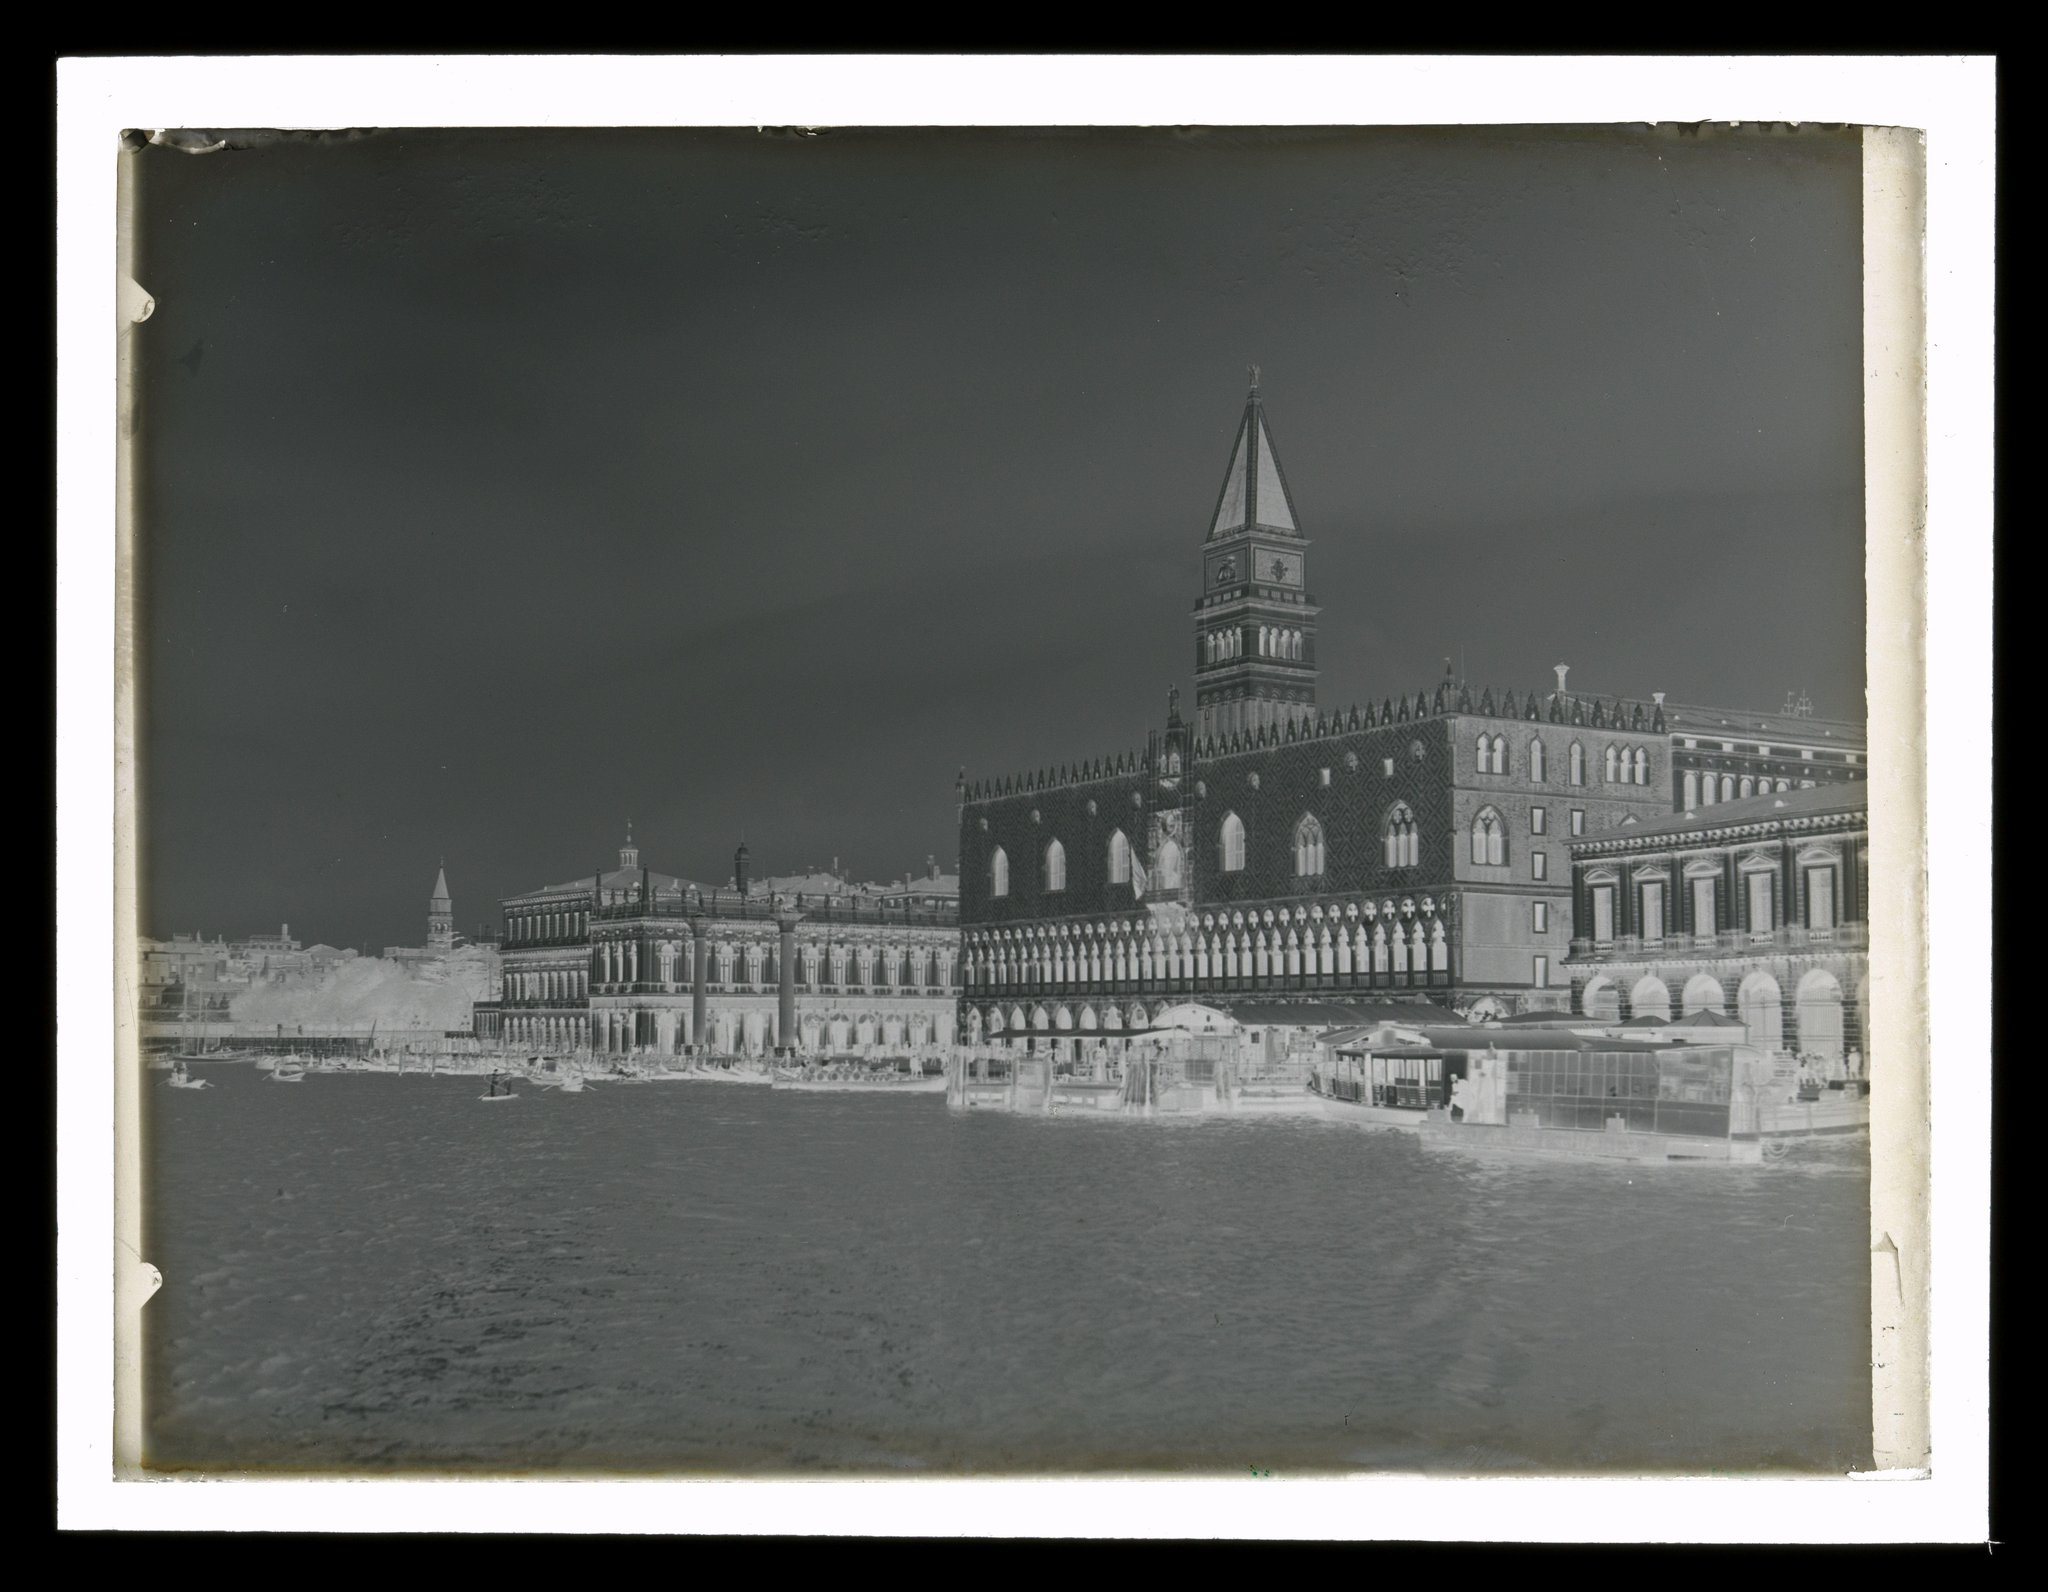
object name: photograph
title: Gezicht op het Dogepaleis vanaf het water, Venetië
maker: Anonymous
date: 1907-1935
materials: glass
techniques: gelatin glass negative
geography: venice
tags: palace